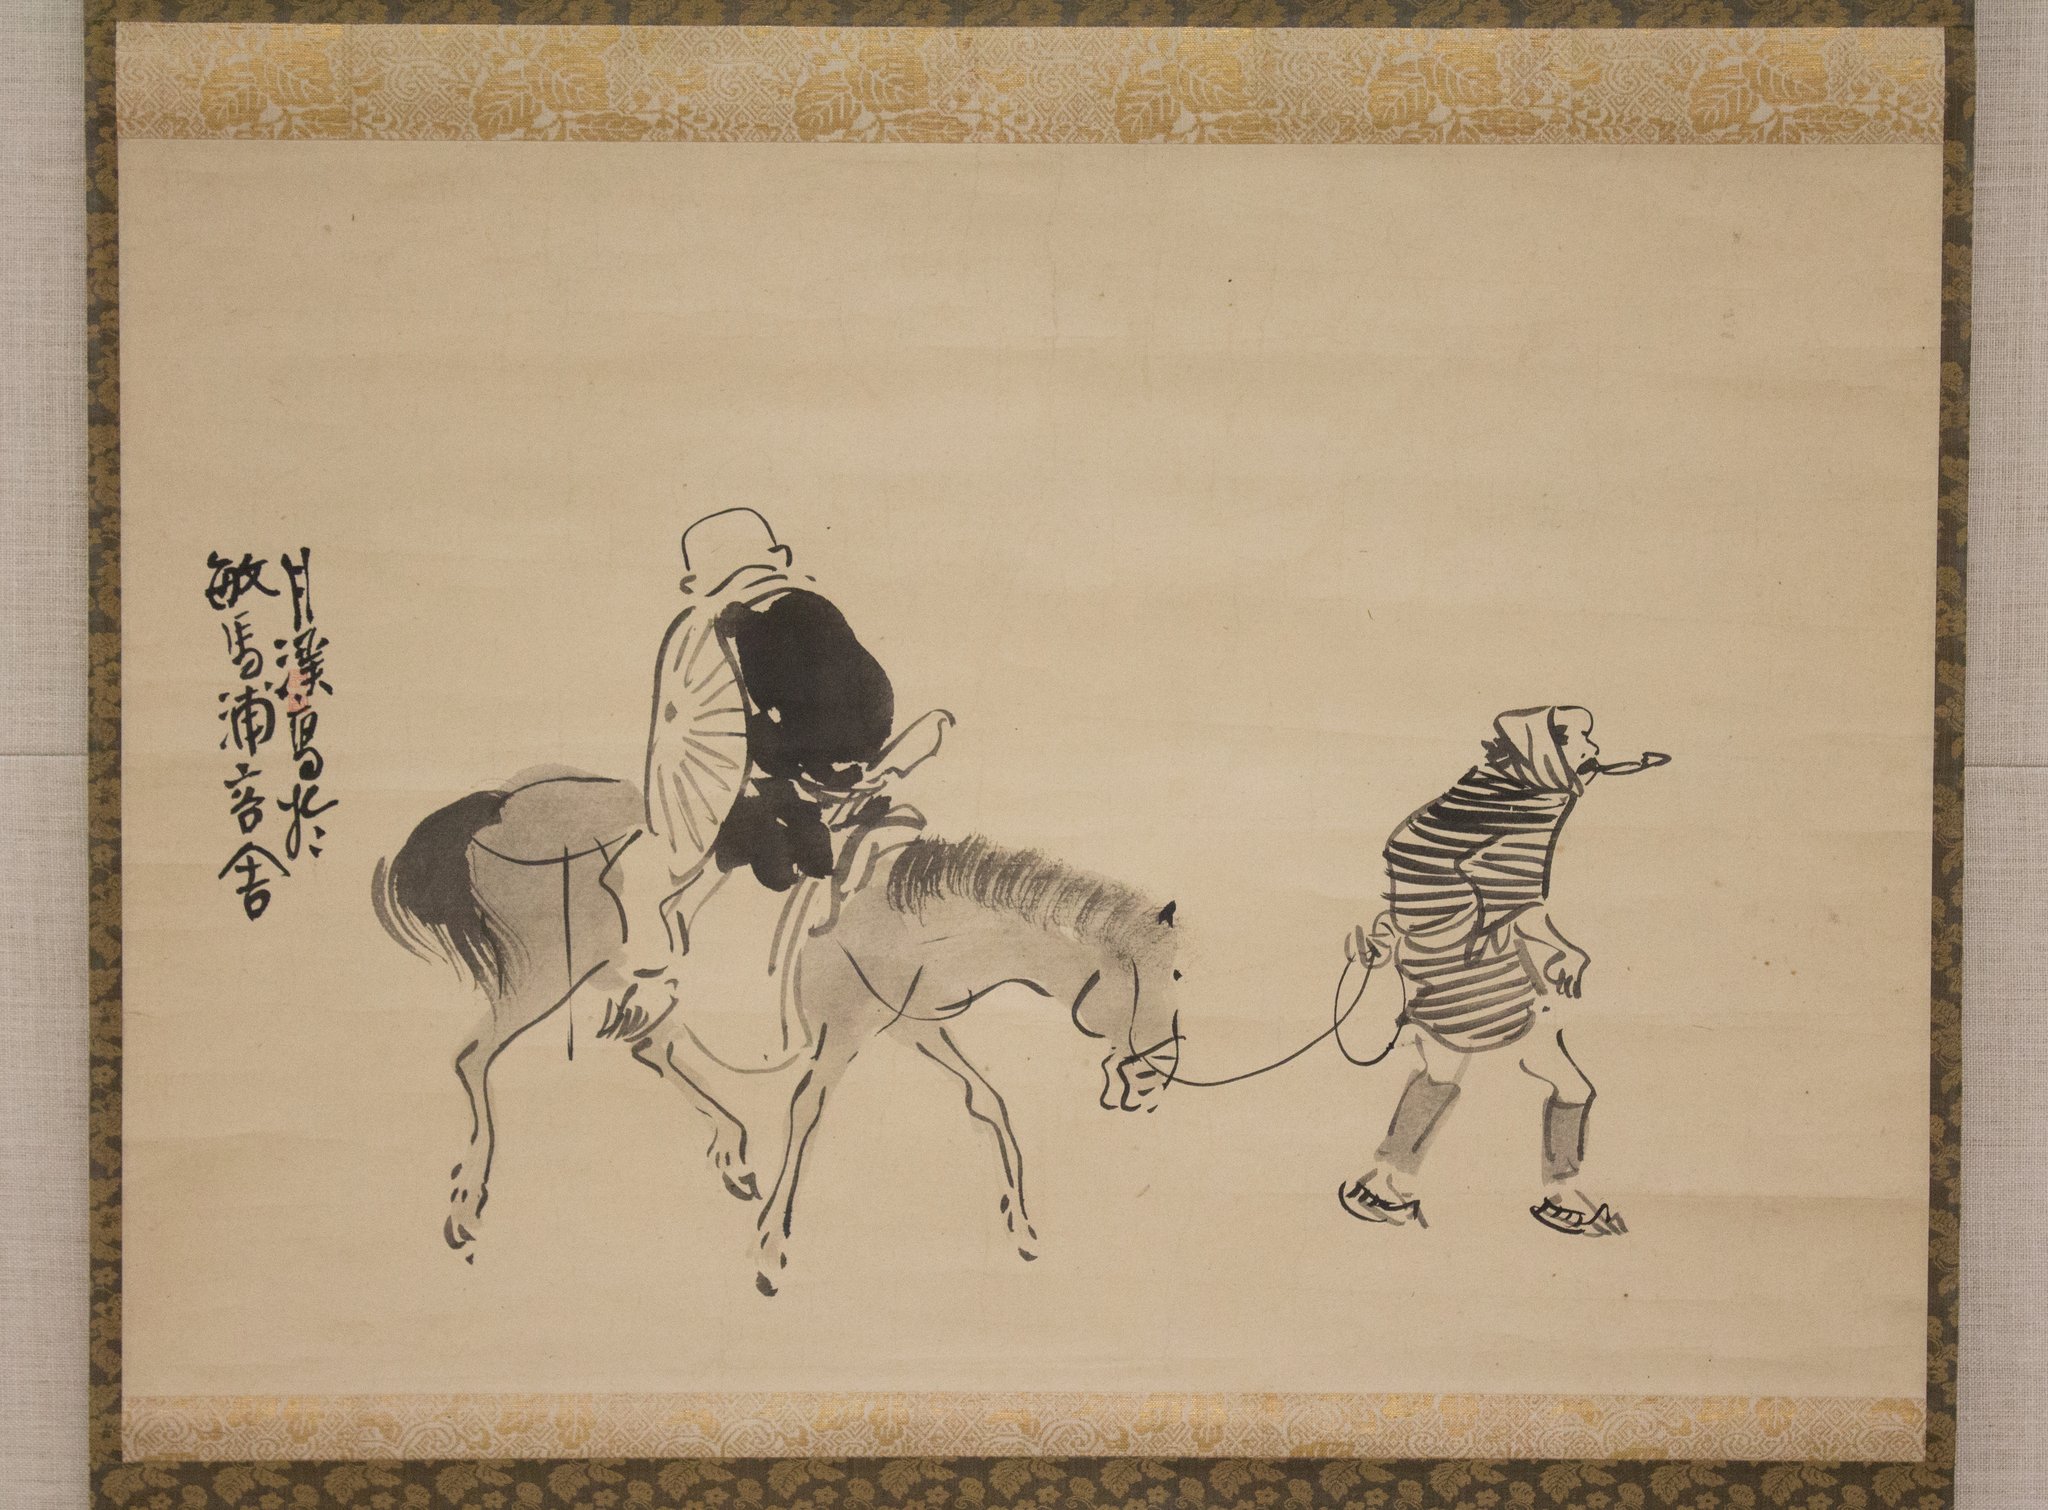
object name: hanging scroll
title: Monk Renshō Riding His Horse Backwards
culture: japanese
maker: matsumura goshun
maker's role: artist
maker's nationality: japanese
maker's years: 1752-1811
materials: ink, paper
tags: men,horses,monks